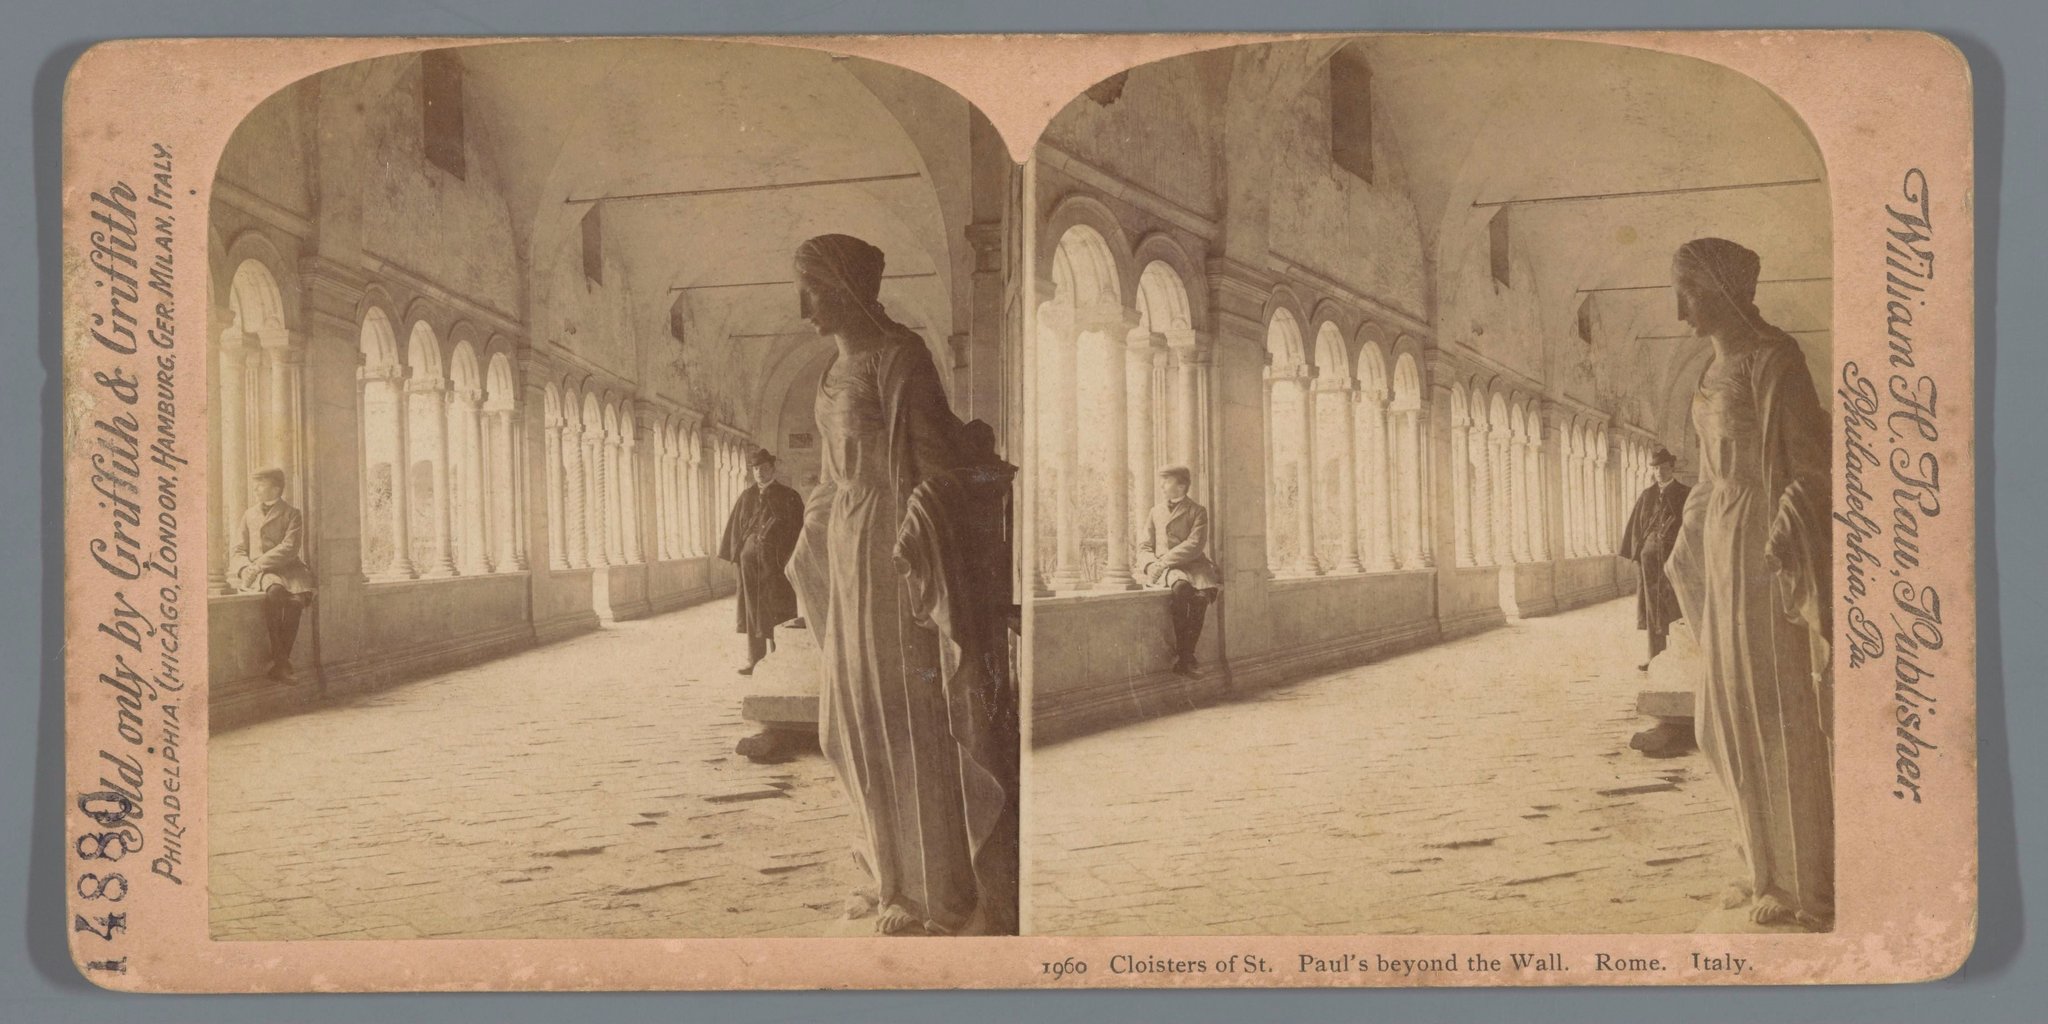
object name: stereograph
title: Cloisters of St. Paul's beyond the Wall. Rome. Italy.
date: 1870-1910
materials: cardboard, photographic support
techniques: albumen print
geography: sint-paulus buiten de muren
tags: cloisters ~ monastery, sculpture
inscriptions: number: ‘14880’, number: ‘1960’, name: ‘Sold only by Griffith & Griffith Philadelphia, Chicago, London, Hamburg, Ger. Milan, Italy.’